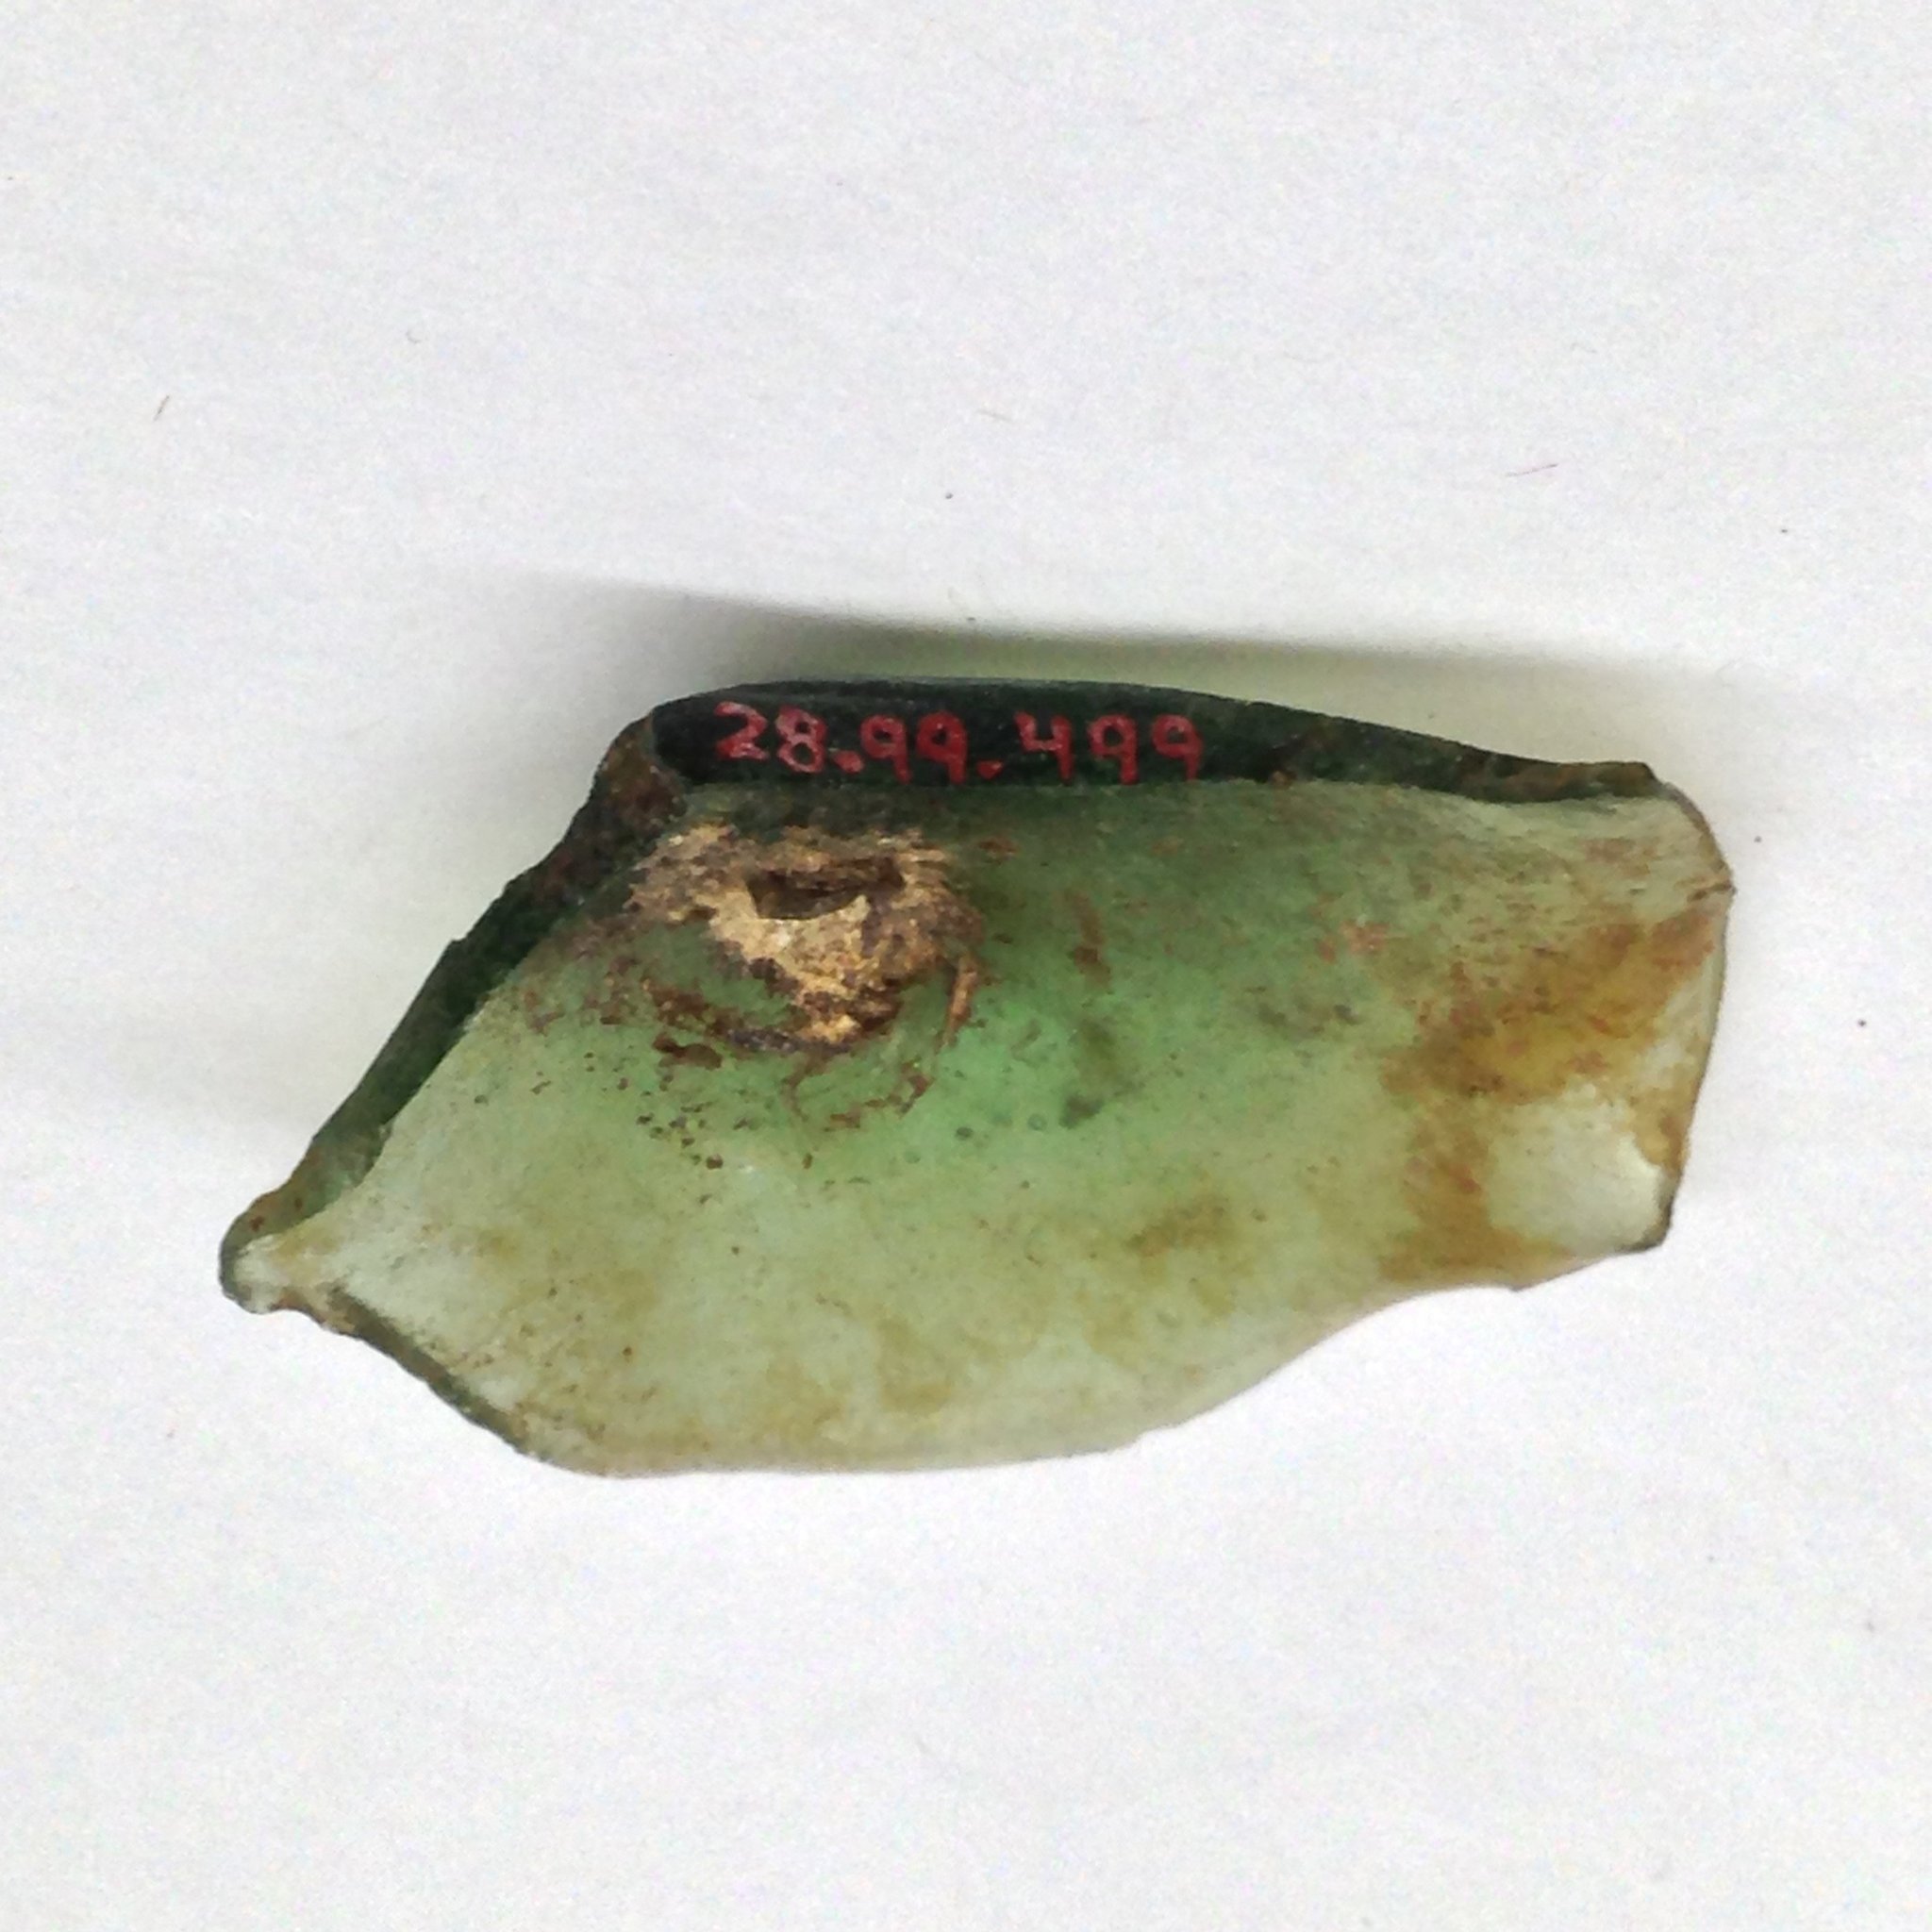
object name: fragment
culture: european or middle eastern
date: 1150-1250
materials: ceramic, glass